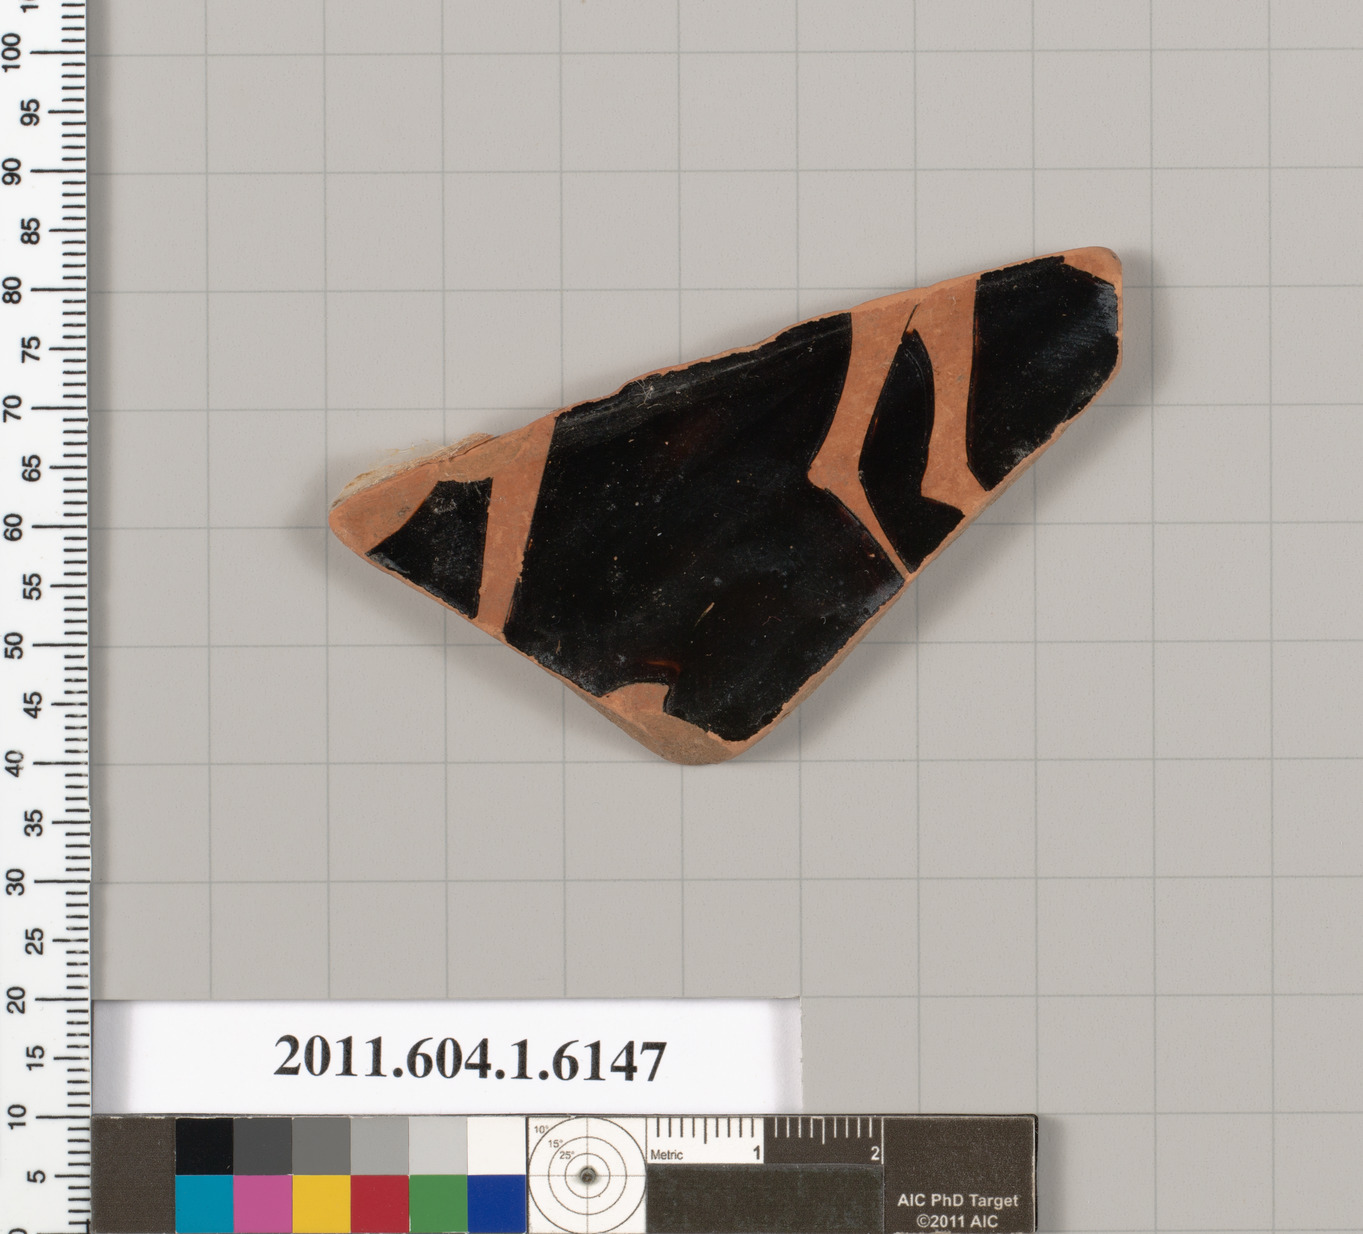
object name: kylix fragment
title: Terracotta fragment of a kylix (drinking cup)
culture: greek, attic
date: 520-500 BCE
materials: terracotta